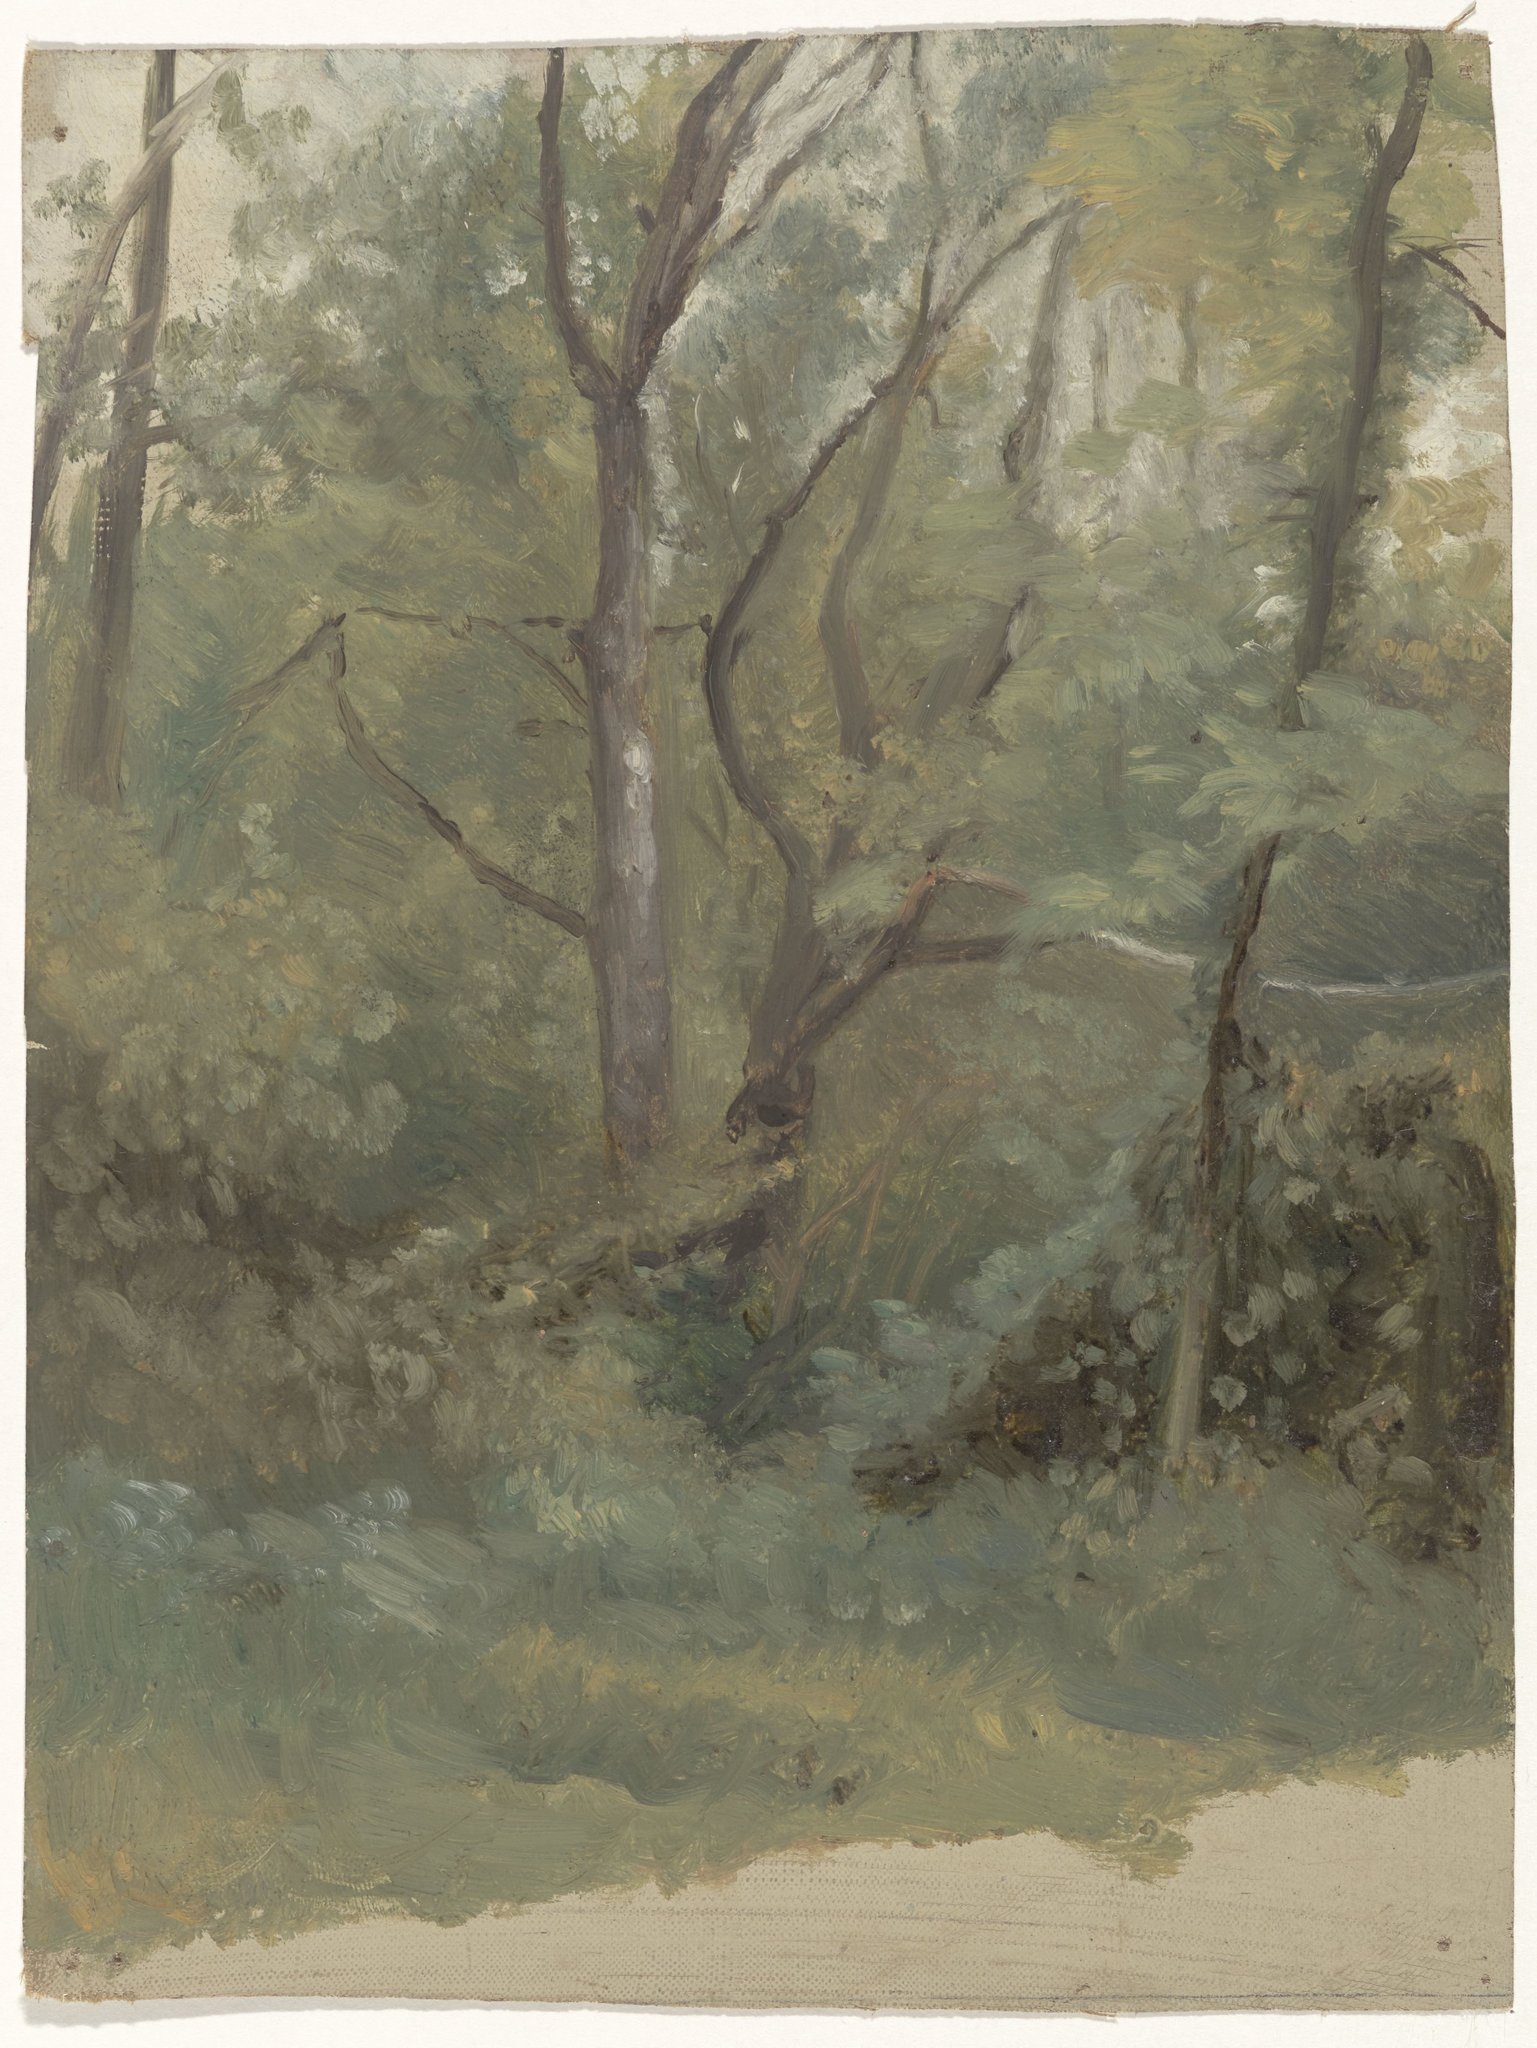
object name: oil sketch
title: Bosgezicht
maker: guillaume anne van der brugghen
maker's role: draughtsman, print maker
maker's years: 1812-1891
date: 1821-1891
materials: linen, oil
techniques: brush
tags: forest, wood